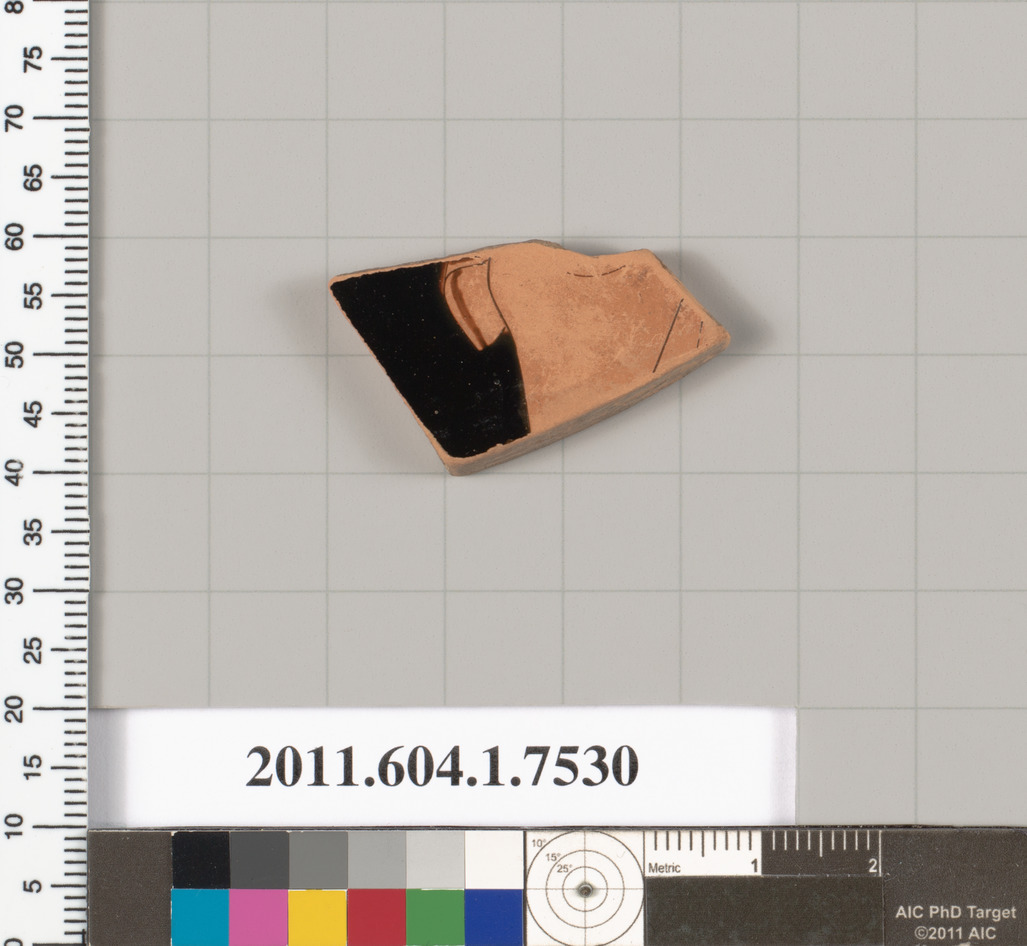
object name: kylix fragment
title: Terracotta fragment of a kylix (drinking cup)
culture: greek, attic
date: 460-450 BCE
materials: terracotta